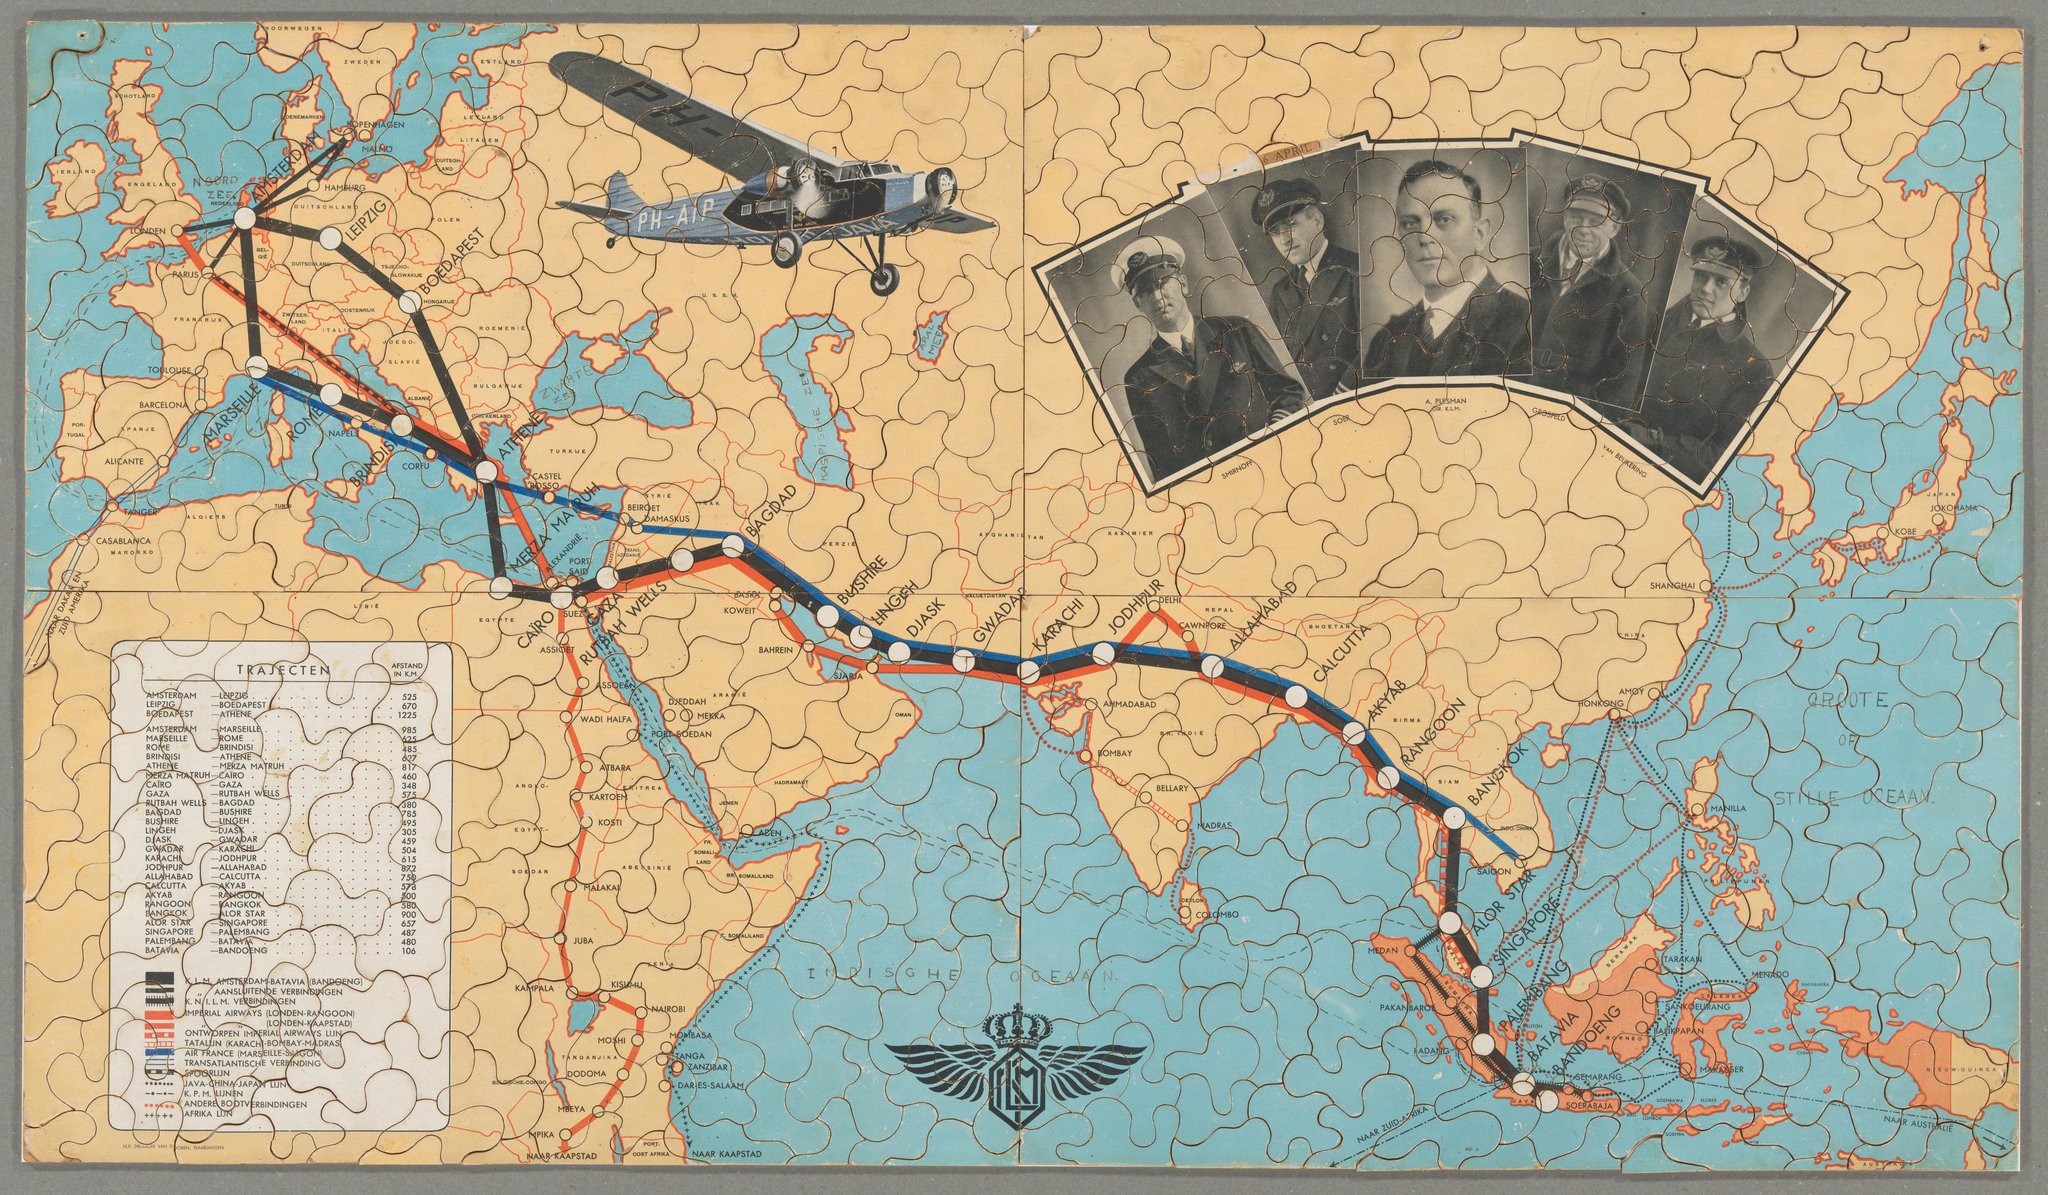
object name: photograph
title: Puzzel met foto van Fokker PH-AIP en haar bemanning tijdens de recordvlucht Londen-Melbourne, 1933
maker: Anonymous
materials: cardboard, photographic support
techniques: lithograph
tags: london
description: Kaart waarop de route is aangegeven en foto's van vliegtuig en bemanningsleden.